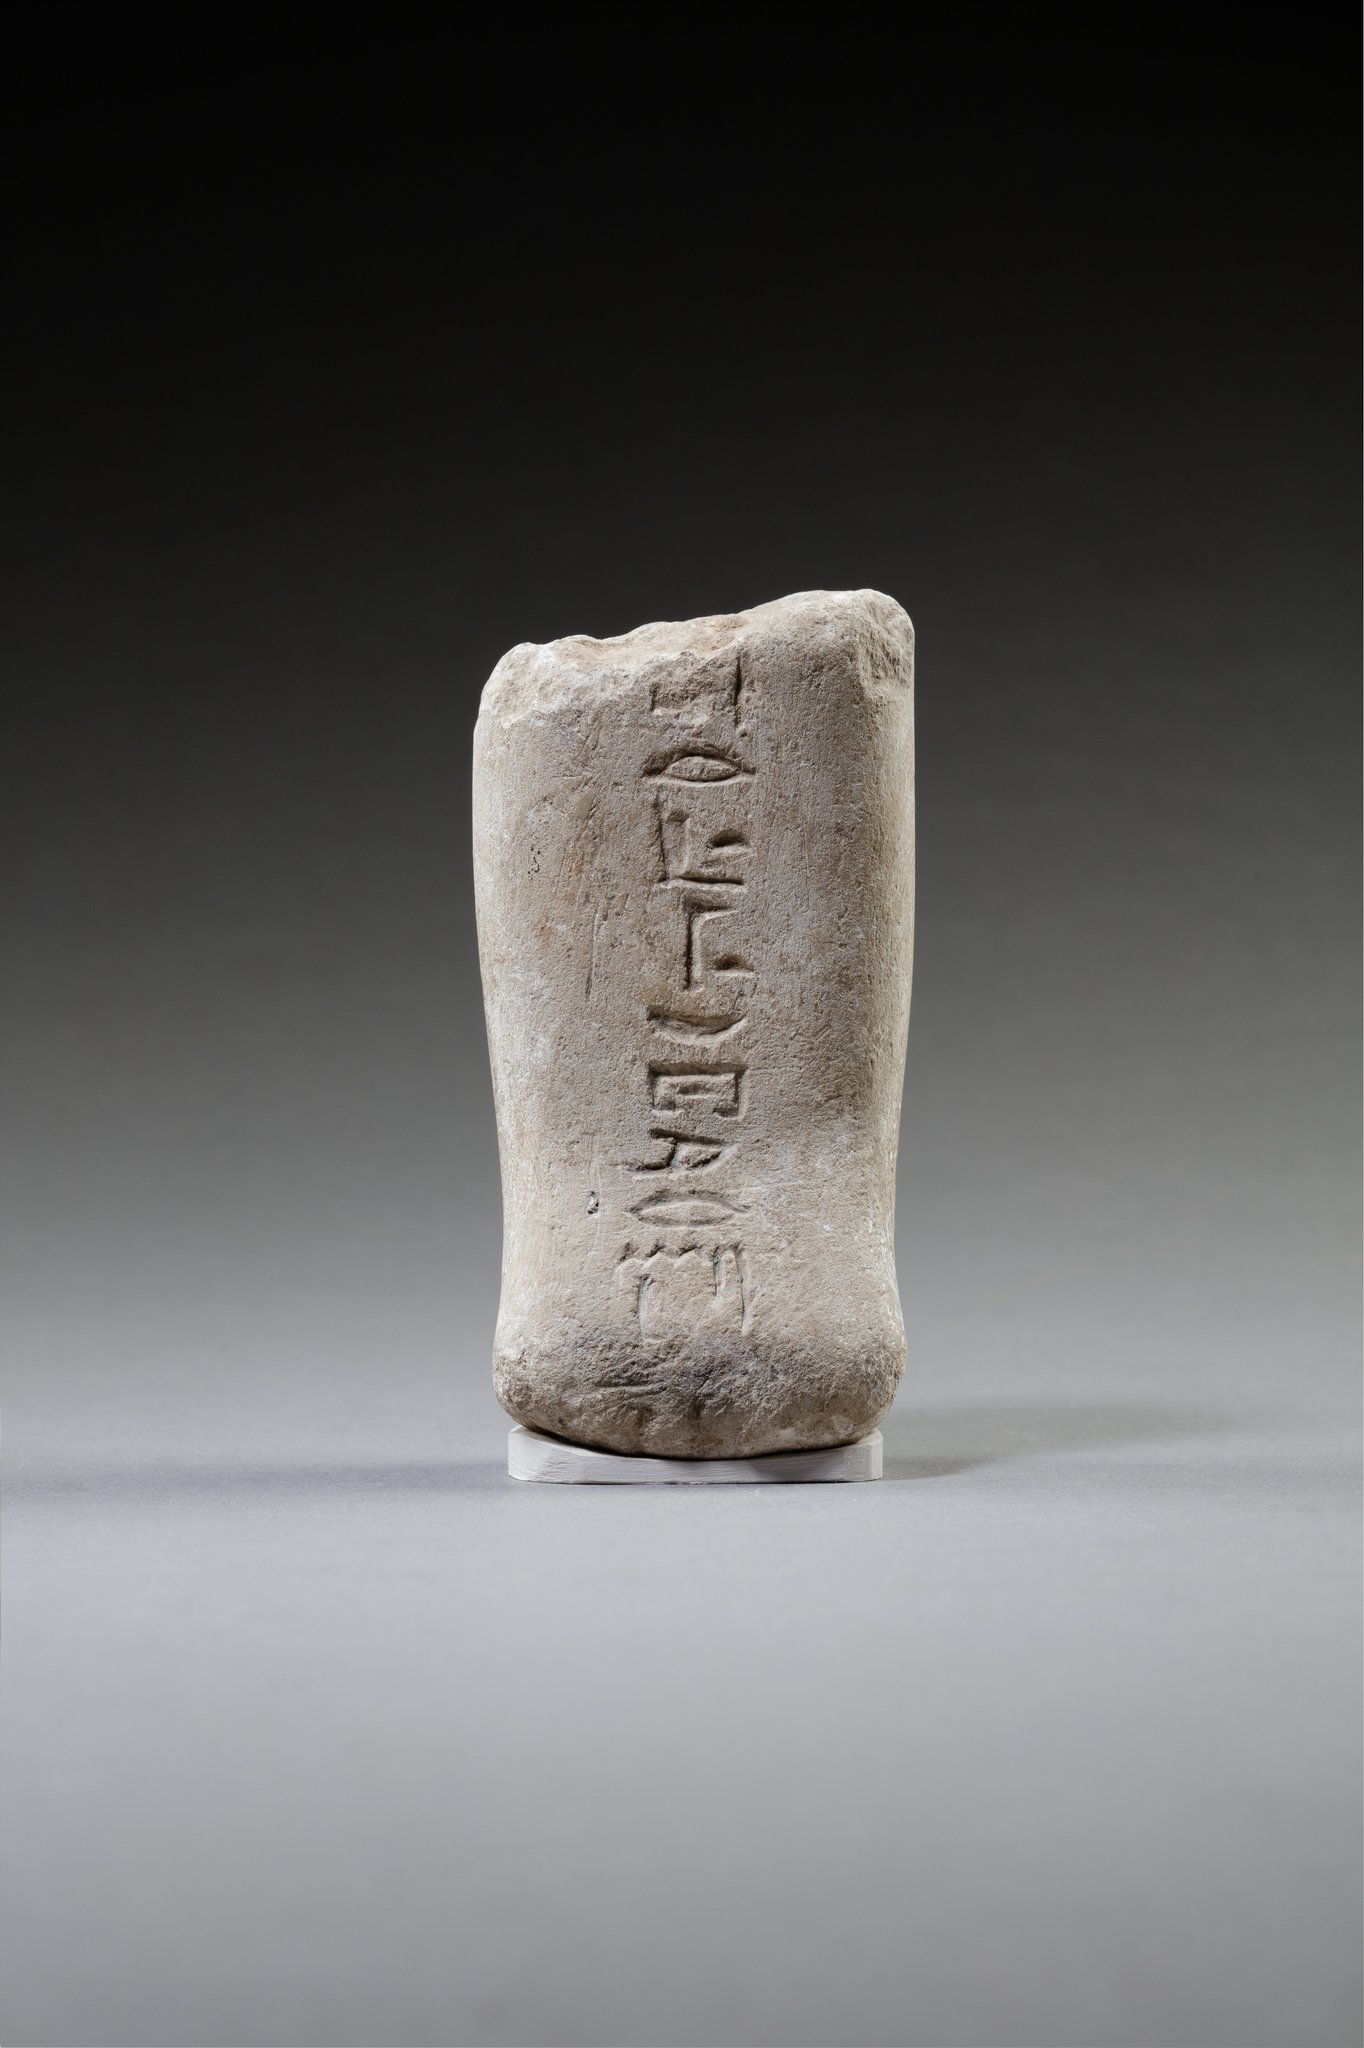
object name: lower part of a shabti, merseneb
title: Lower part of a shabti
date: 1981-1640 BCE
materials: limestone, paint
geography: egypt